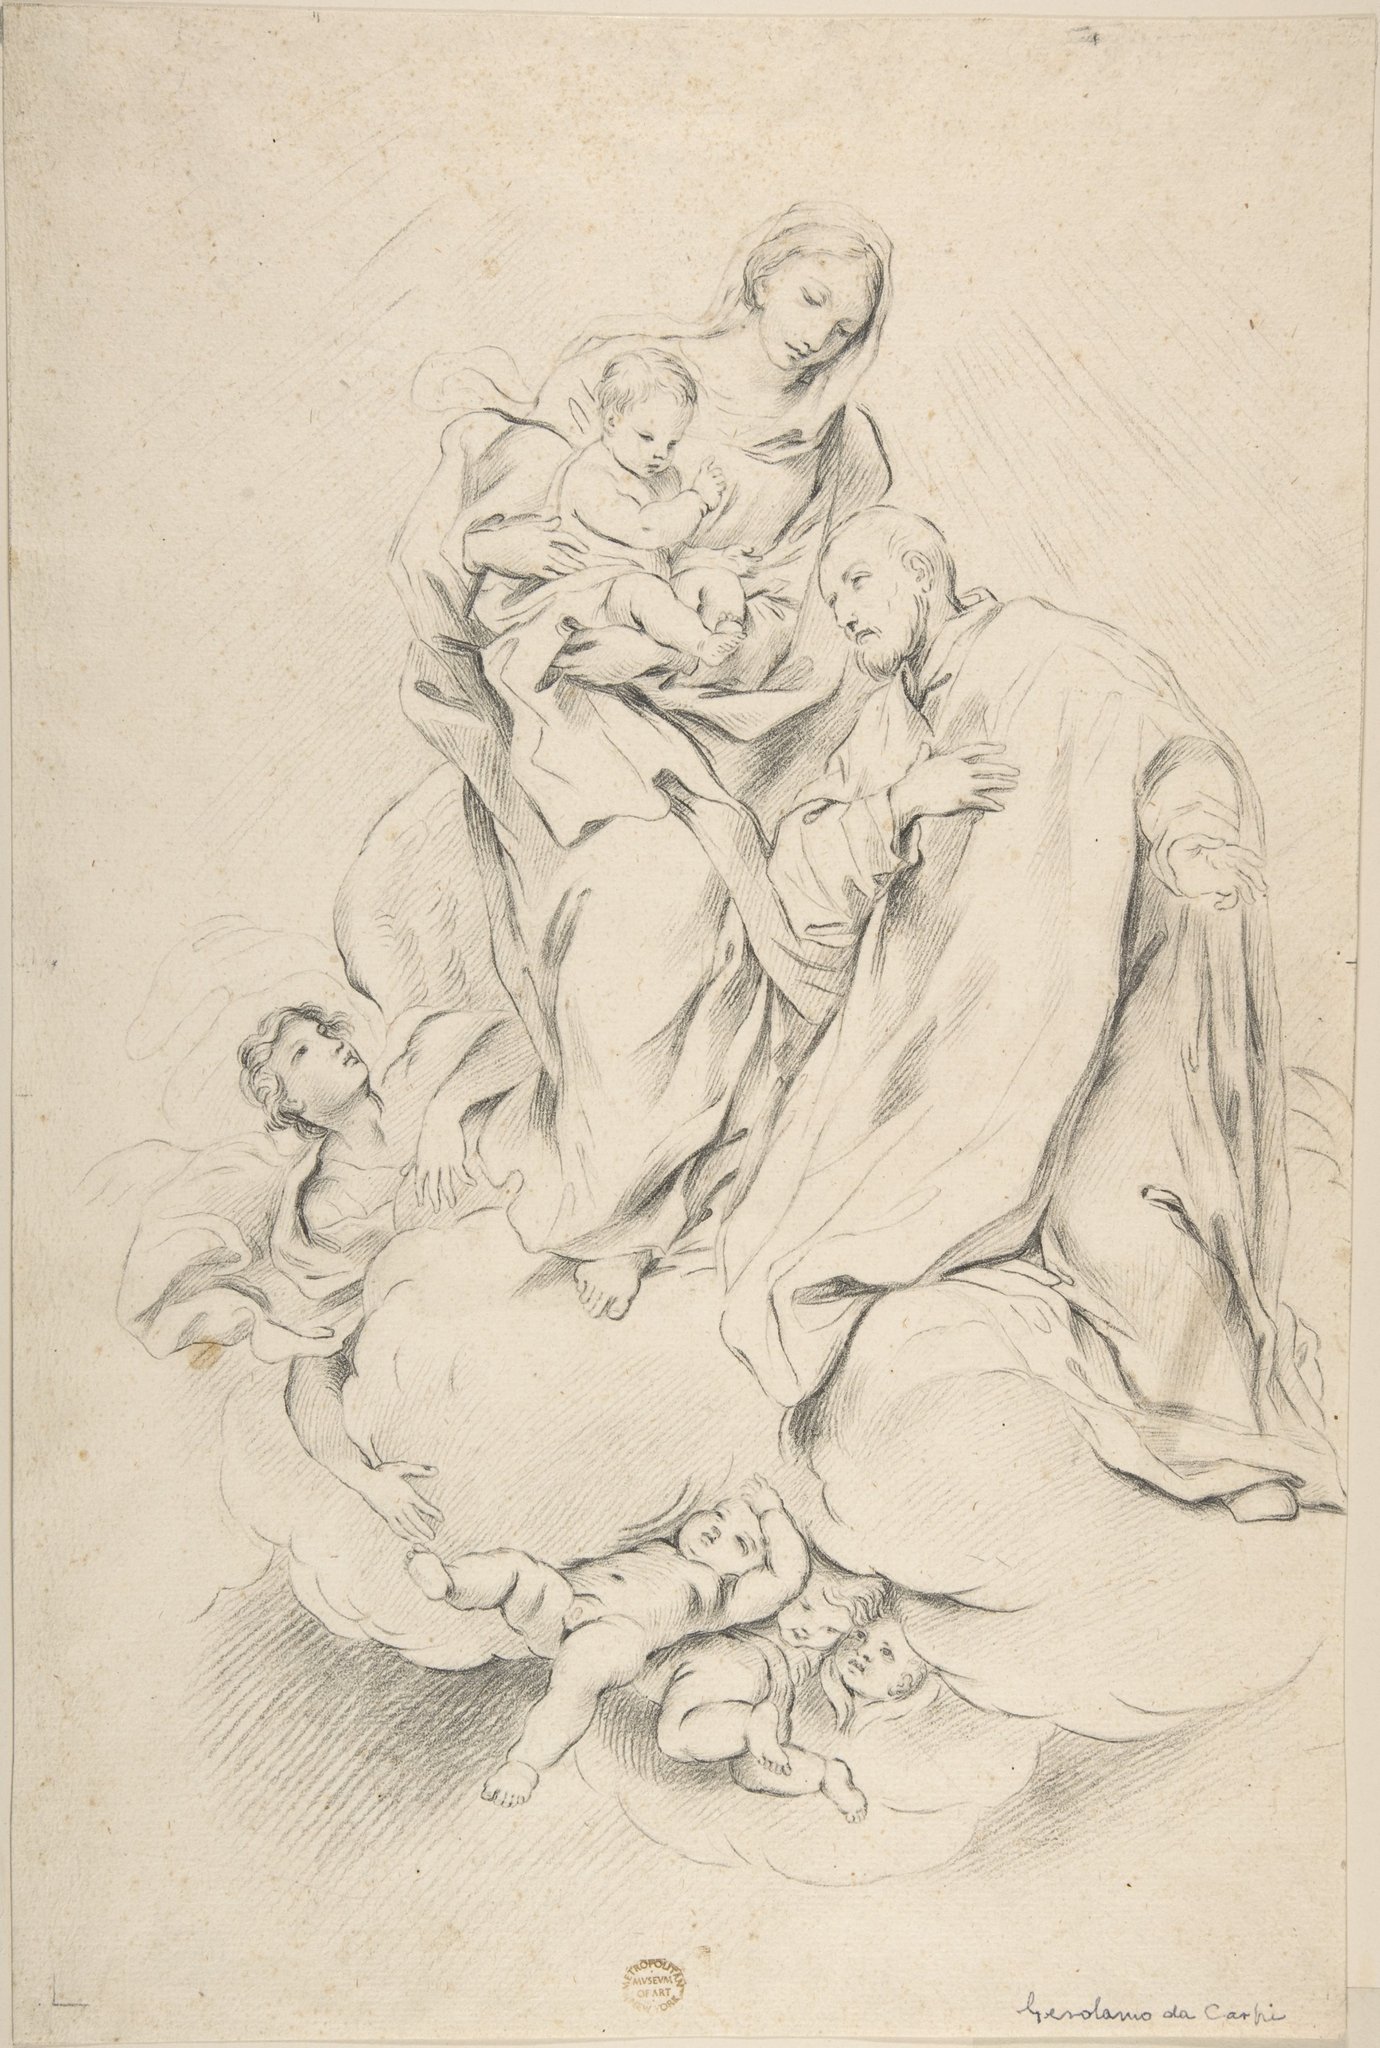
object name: drawing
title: Holy Family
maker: anonymous, italian, 18th century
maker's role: artist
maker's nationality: italian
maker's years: 1700-1800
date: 1701-1800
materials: chalk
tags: infants,men,women,holy family